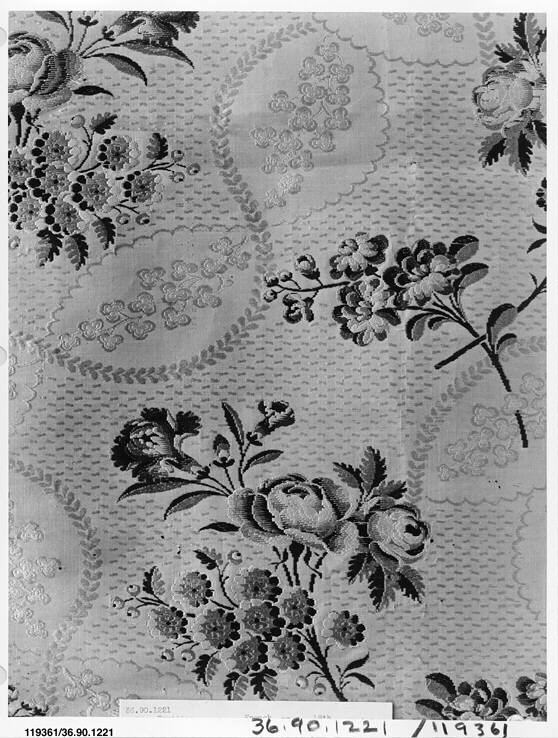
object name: piece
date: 1750-1760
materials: silk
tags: flowers,leaves